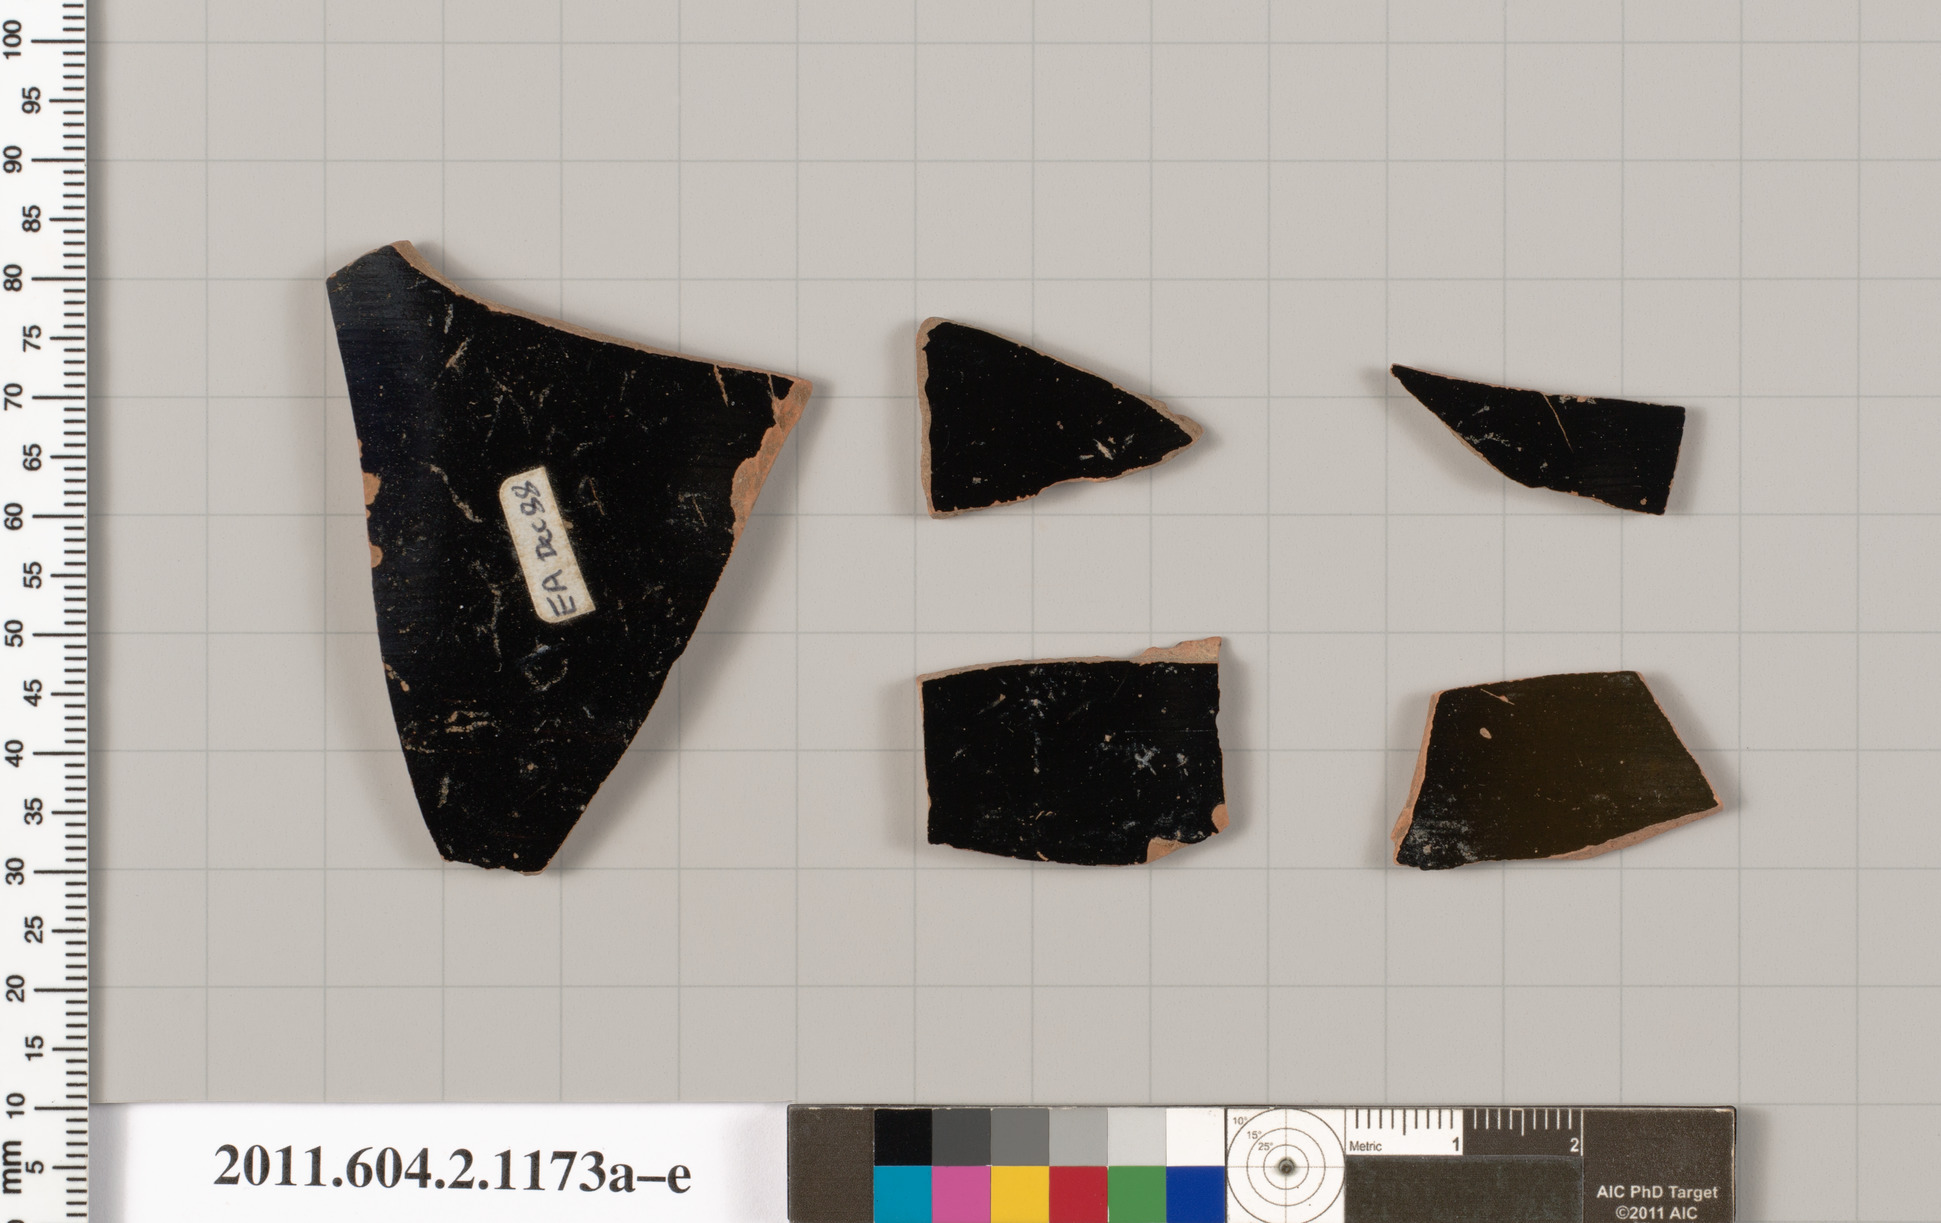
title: Terracotta fragments of closed shapes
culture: greek, attic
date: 475-400 BCE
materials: terracotta